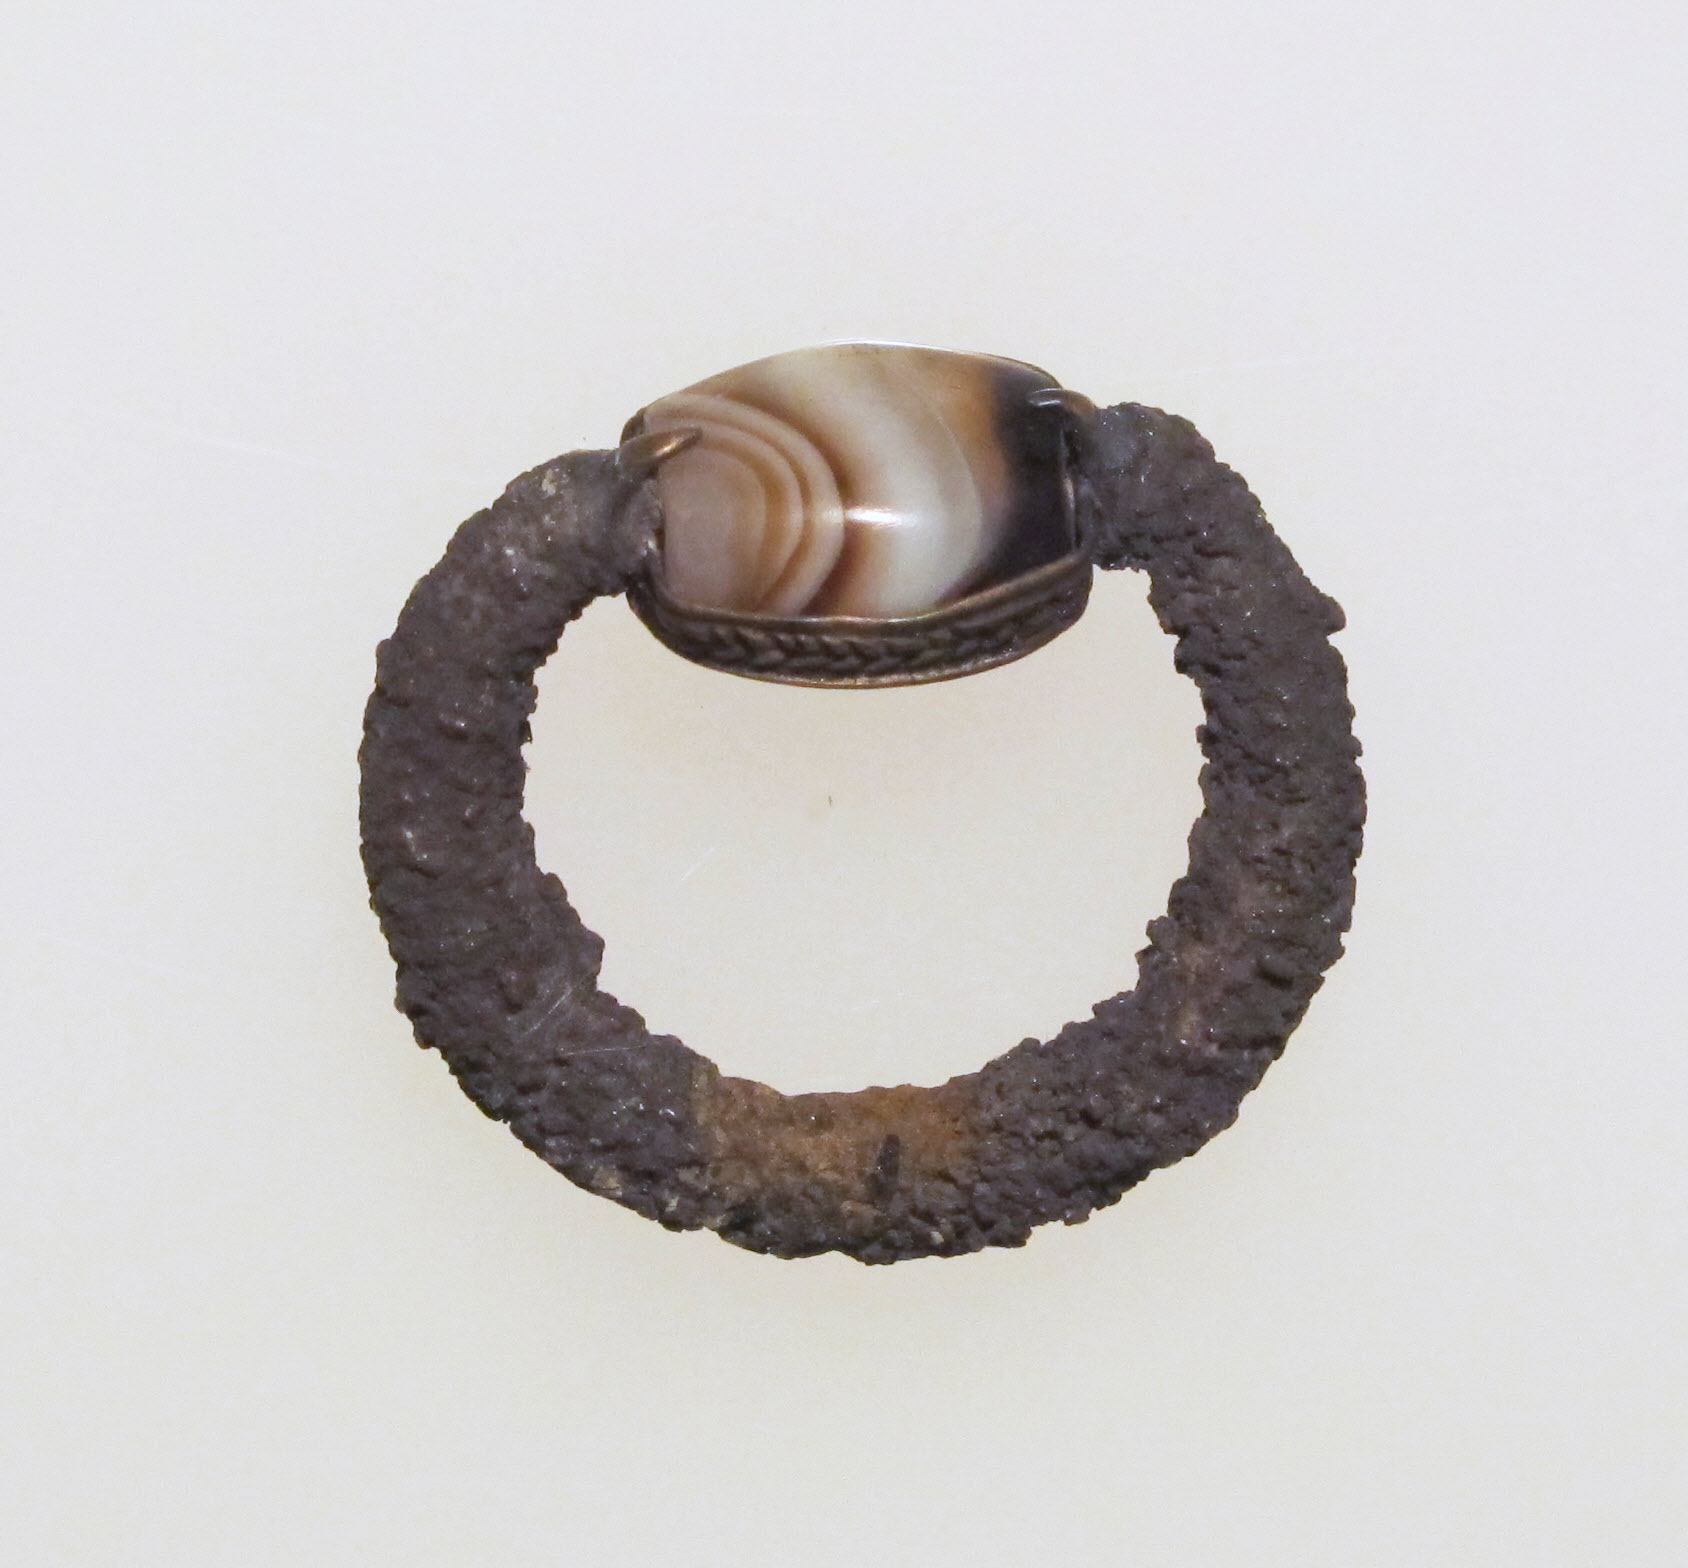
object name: ring with scaraboid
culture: cypriot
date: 600-501 BCE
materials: stone, silver